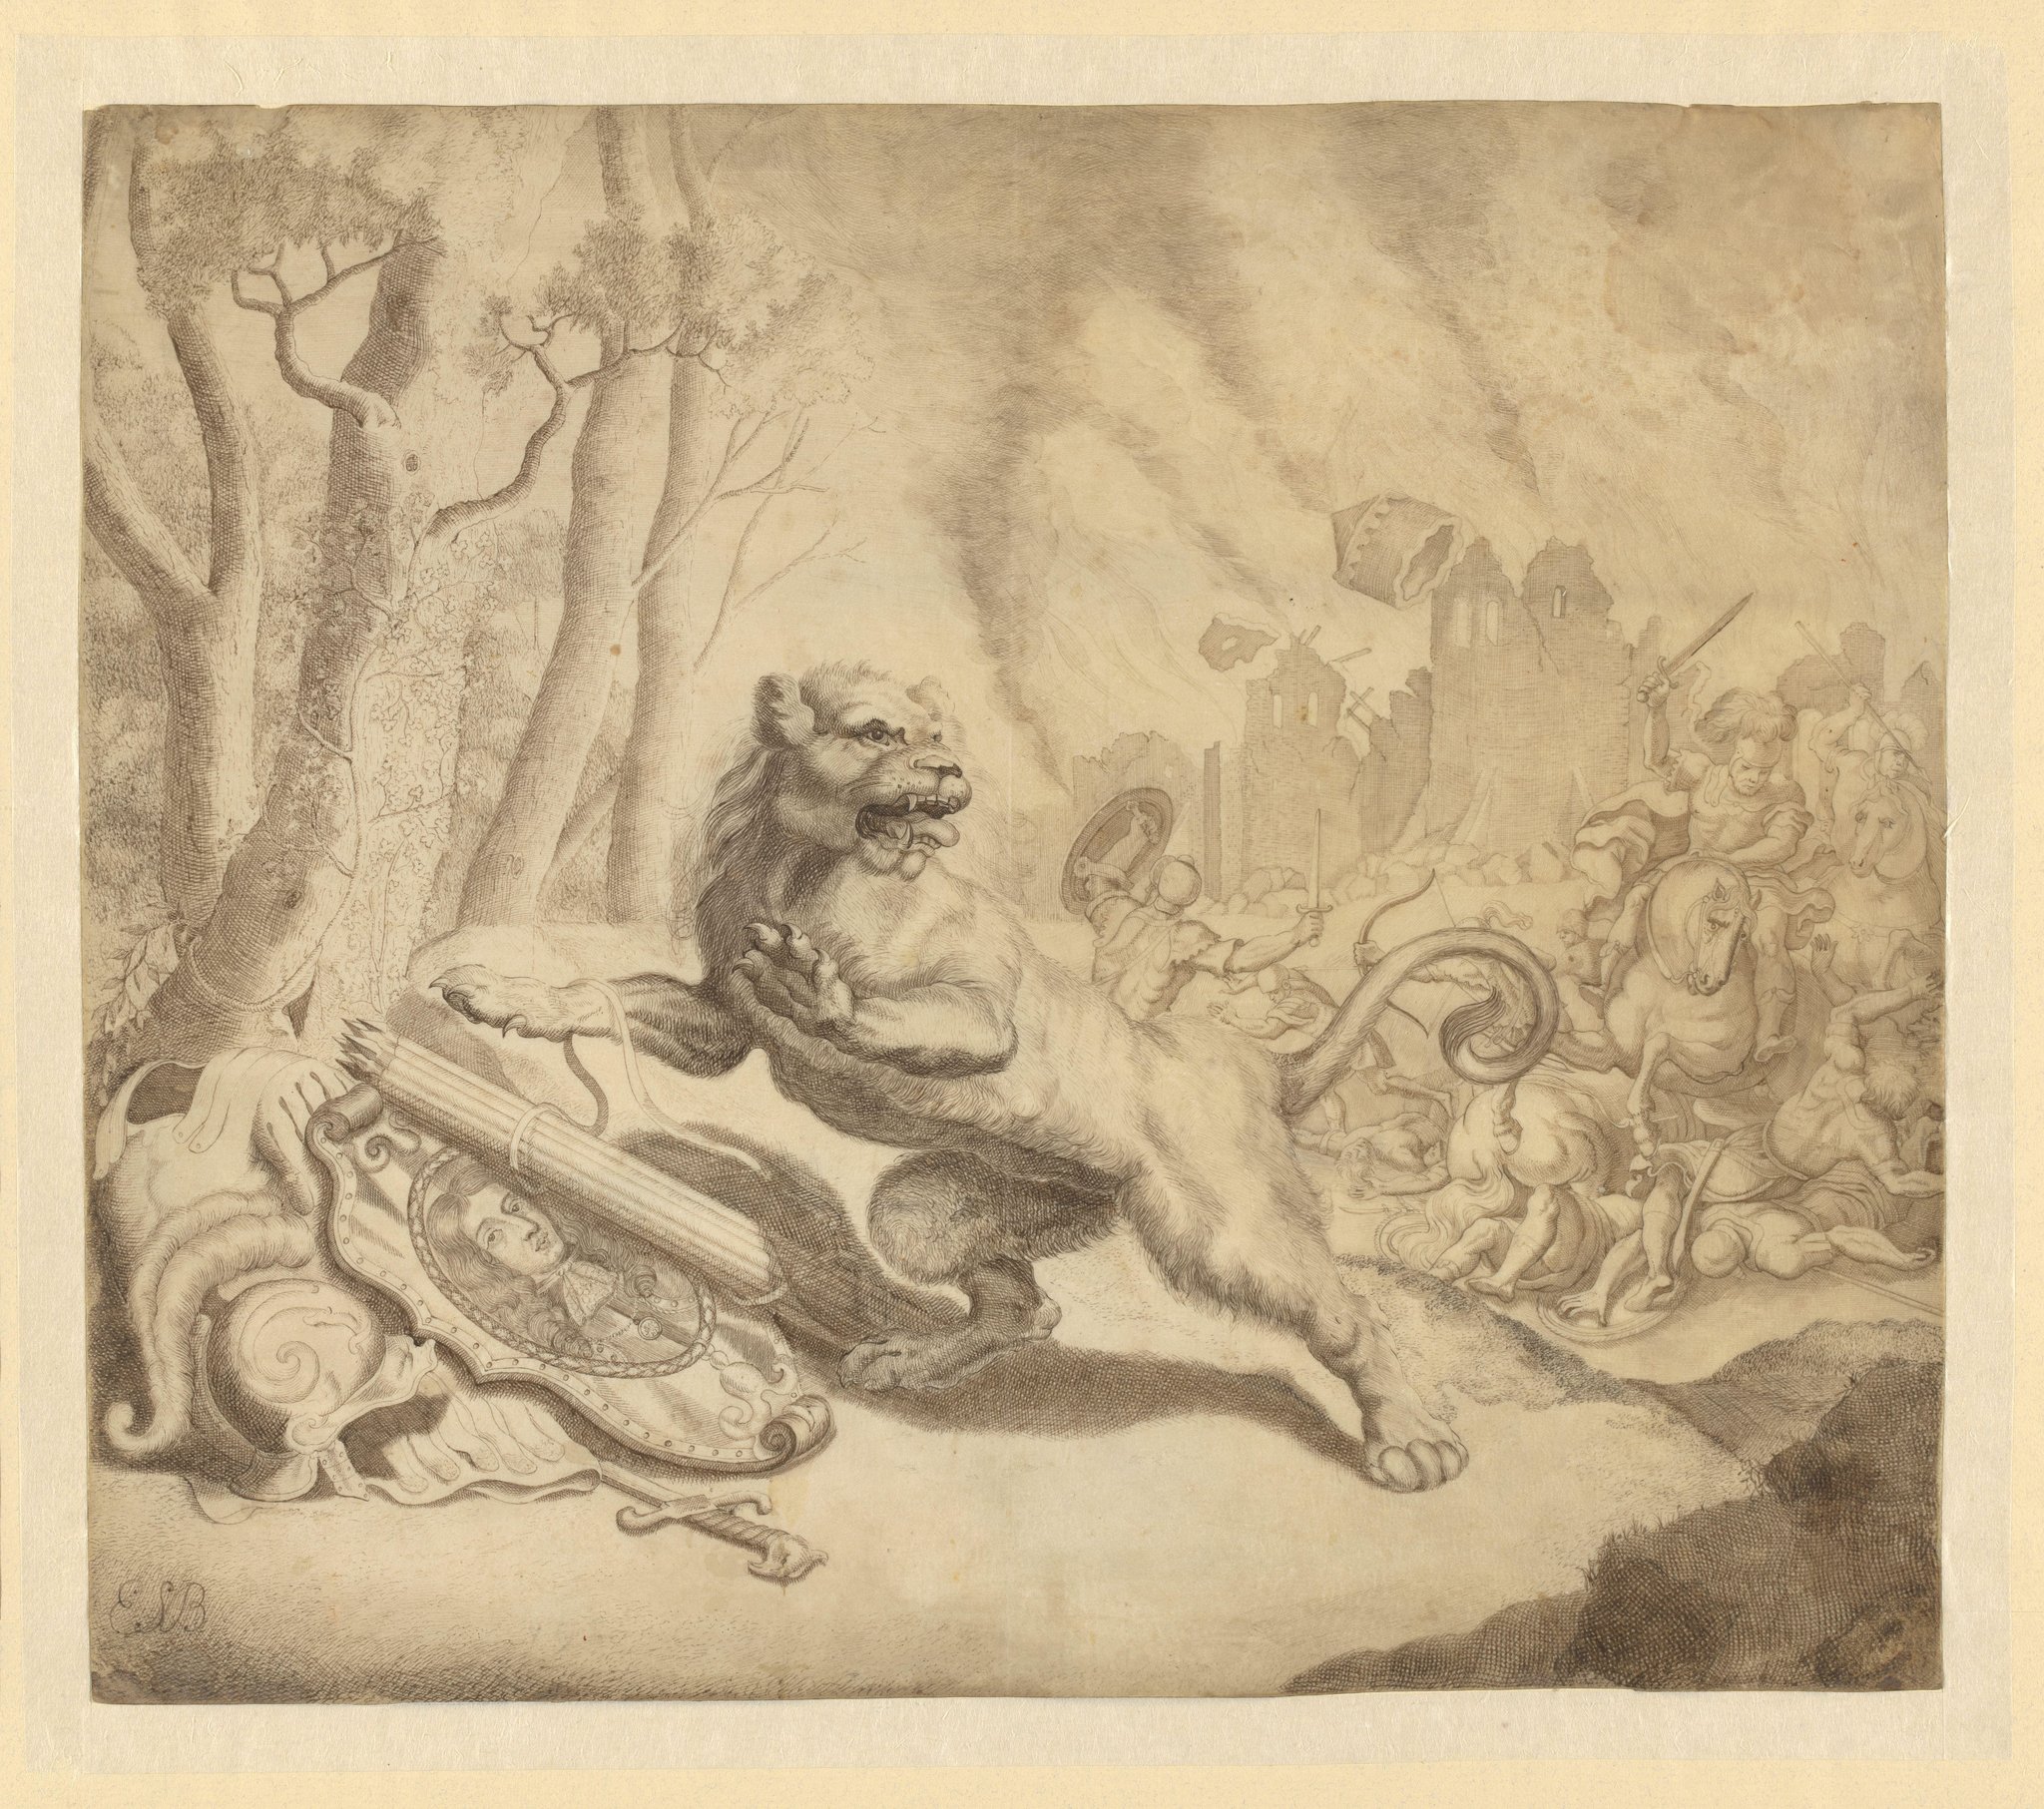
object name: drawing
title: De Nederlandse leeuw zoekt hulp bij Willem III, 1672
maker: monogrammist esb (tekenaar)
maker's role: draughtsman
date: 1672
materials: ink, parchment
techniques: pen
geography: northern netherlands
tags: the hague, william iii (prince of orange and king of england, scotland, and ireland), battle (+ land forces)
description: Allegorische voorstelling uit 1672 met de Nederlandse leeuw bij een schild met het portret van Willem III. Bij het schild liggen andere delen van een wapenrusting en de Nederlandse pijlenbundel, als symbool van de eendracht der zeven Nederlandse provincies. In het omringende landschap woedt de oorlog. De leeuw is gekopieerd naar een prent van Abraham Blooteling.